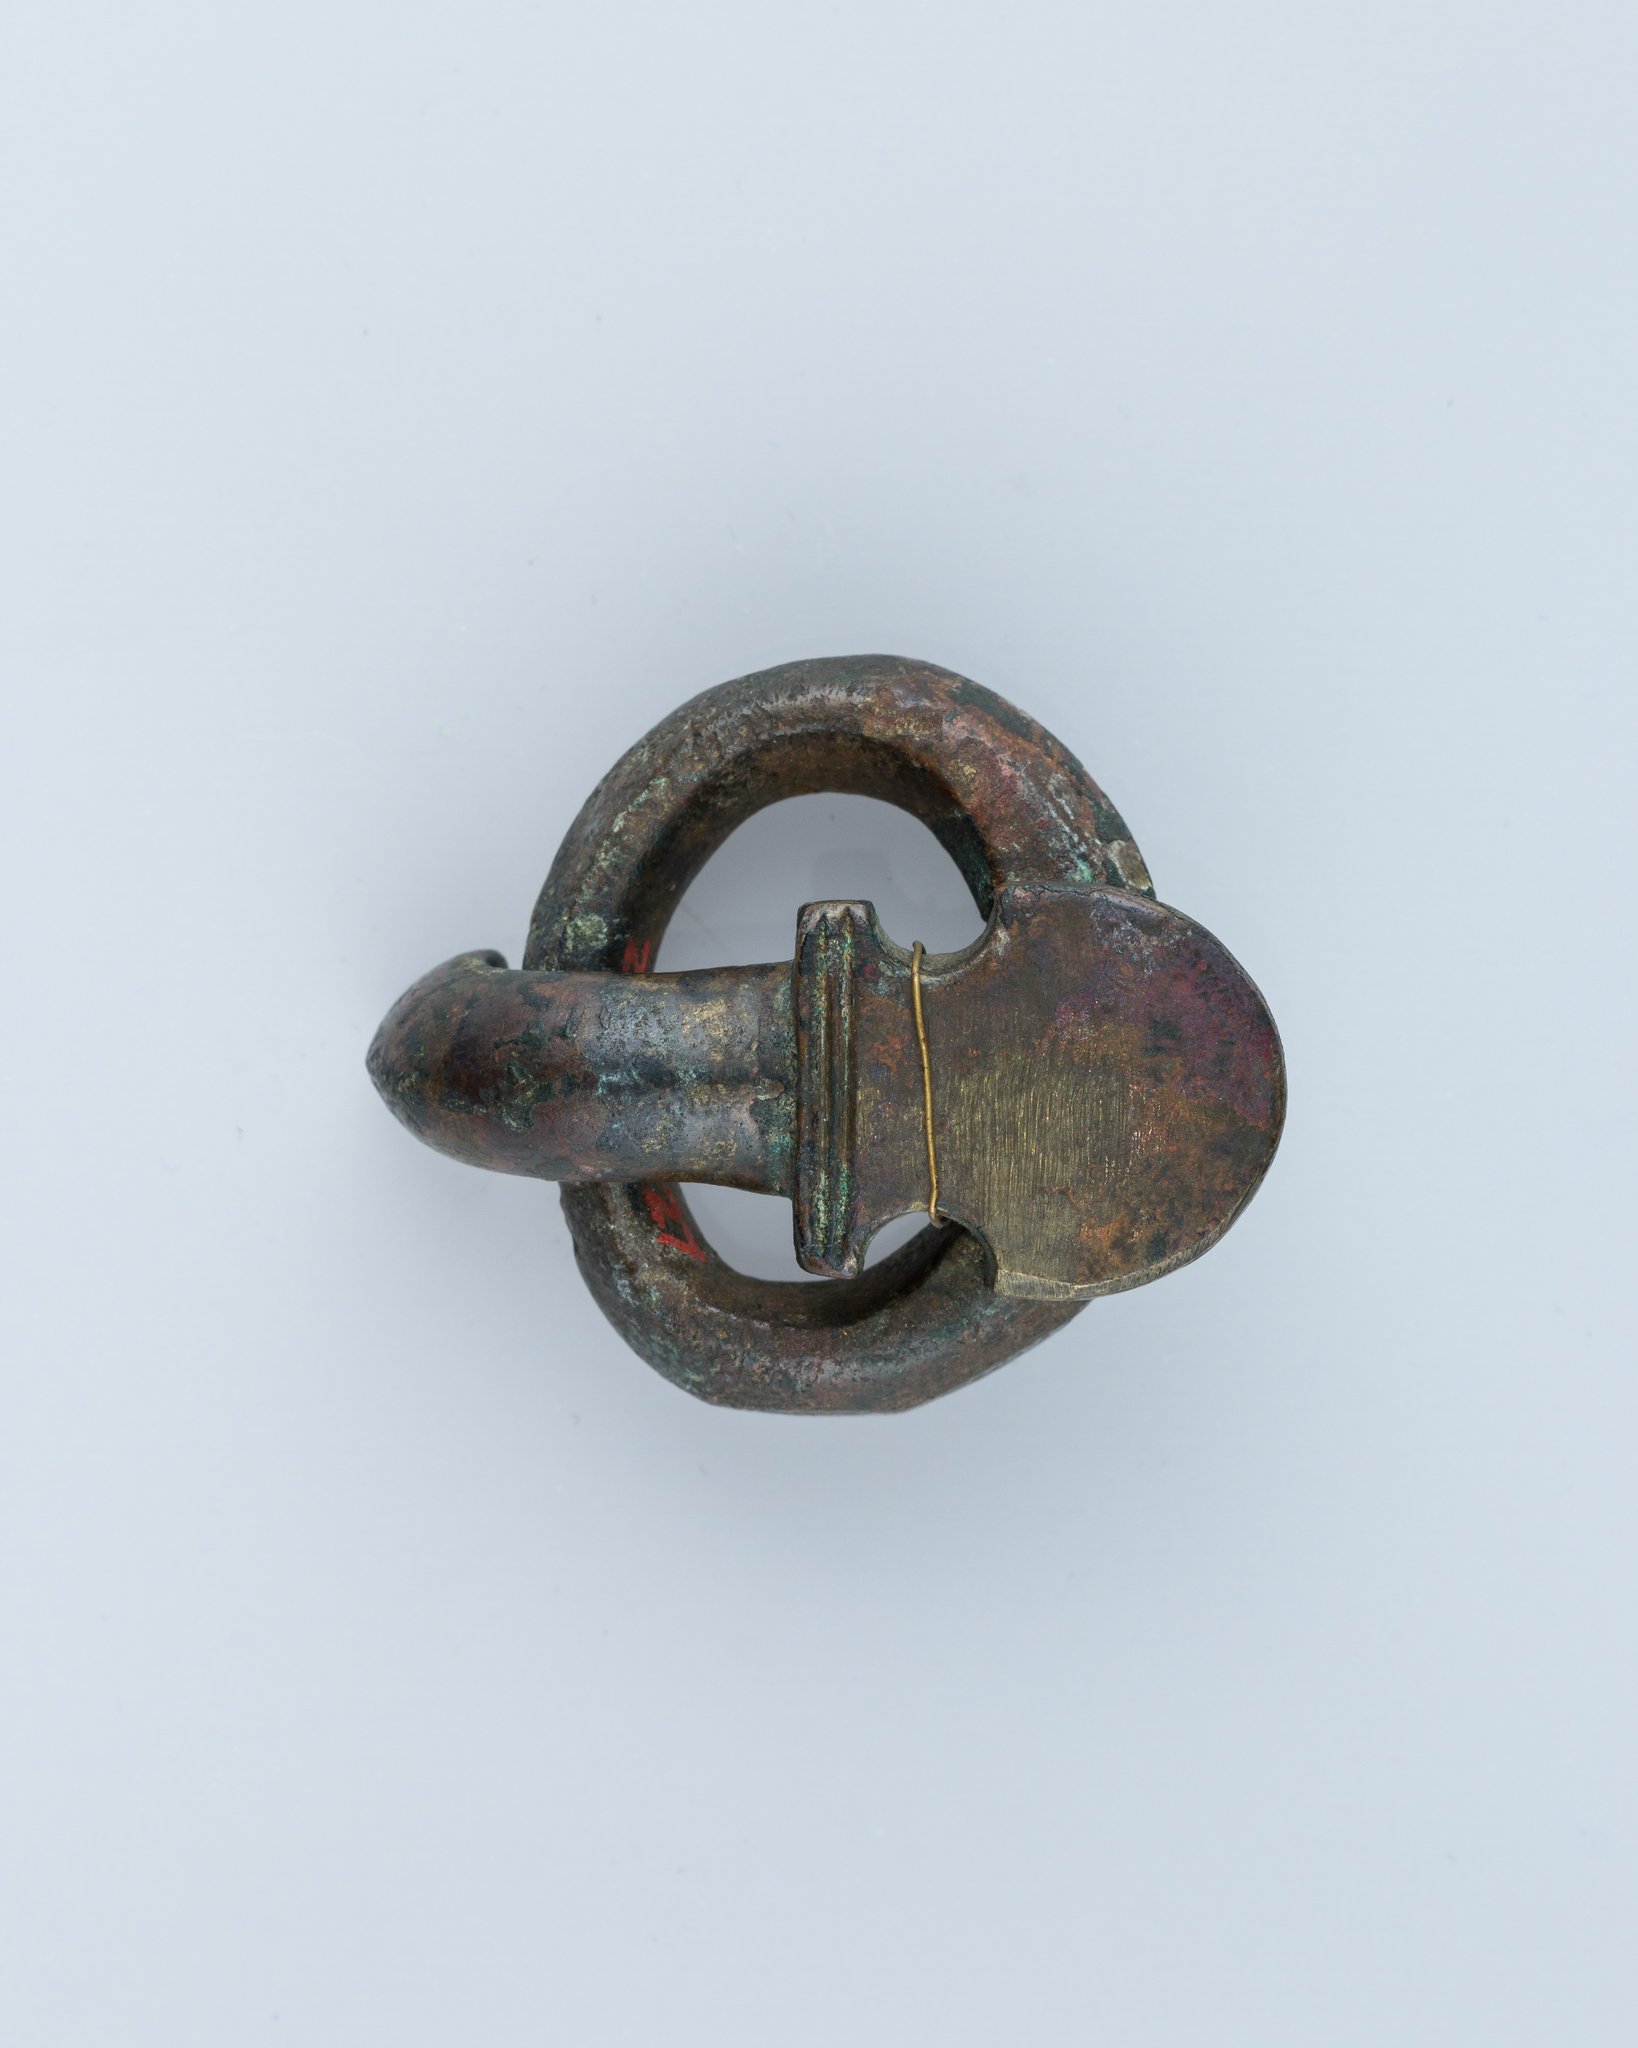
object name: buckle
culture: visigothic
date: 409-711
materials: bronze